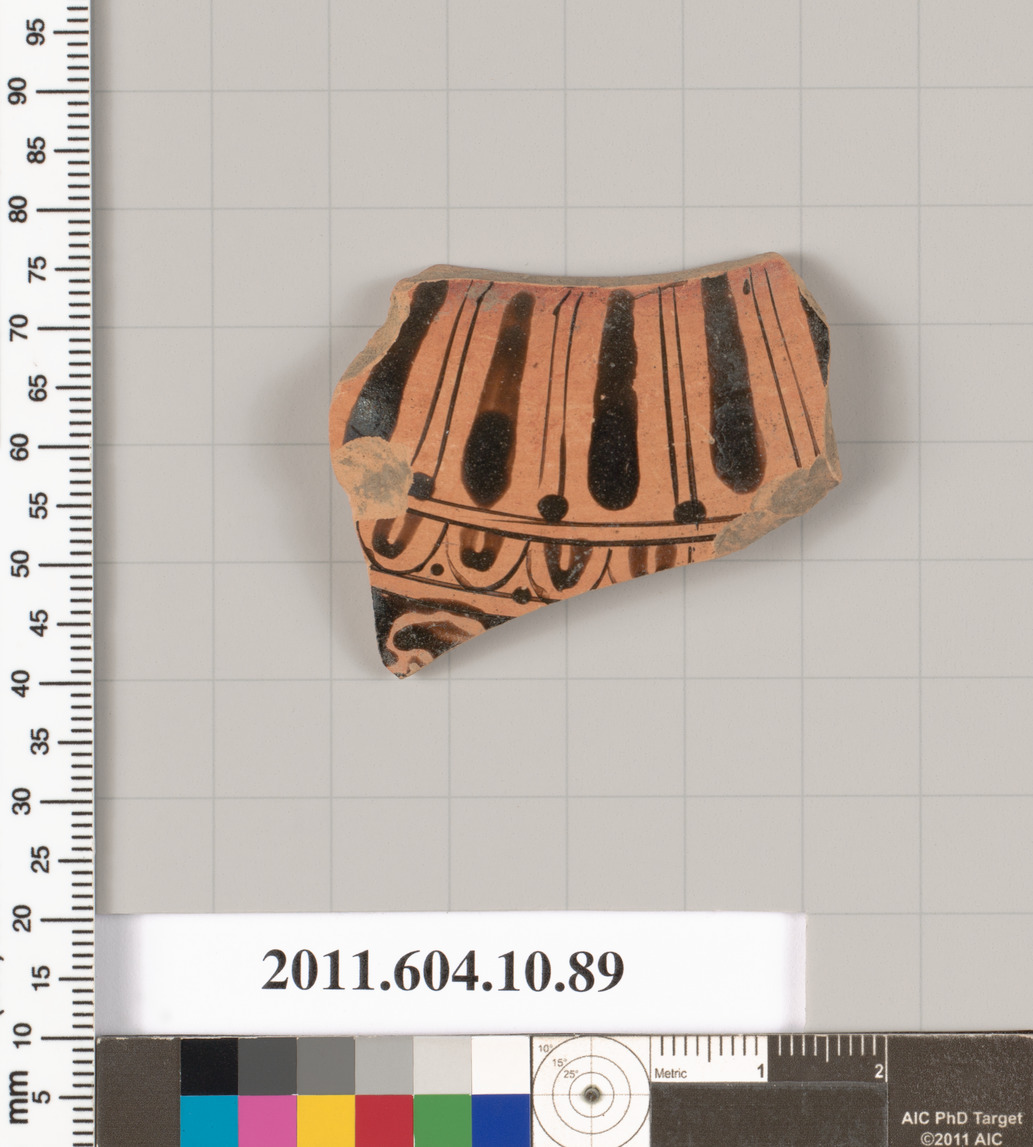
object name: undetermined closed shape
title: Terracotta fragment of a closed shape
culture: etruscan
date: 400-301 BCE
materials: terracotta